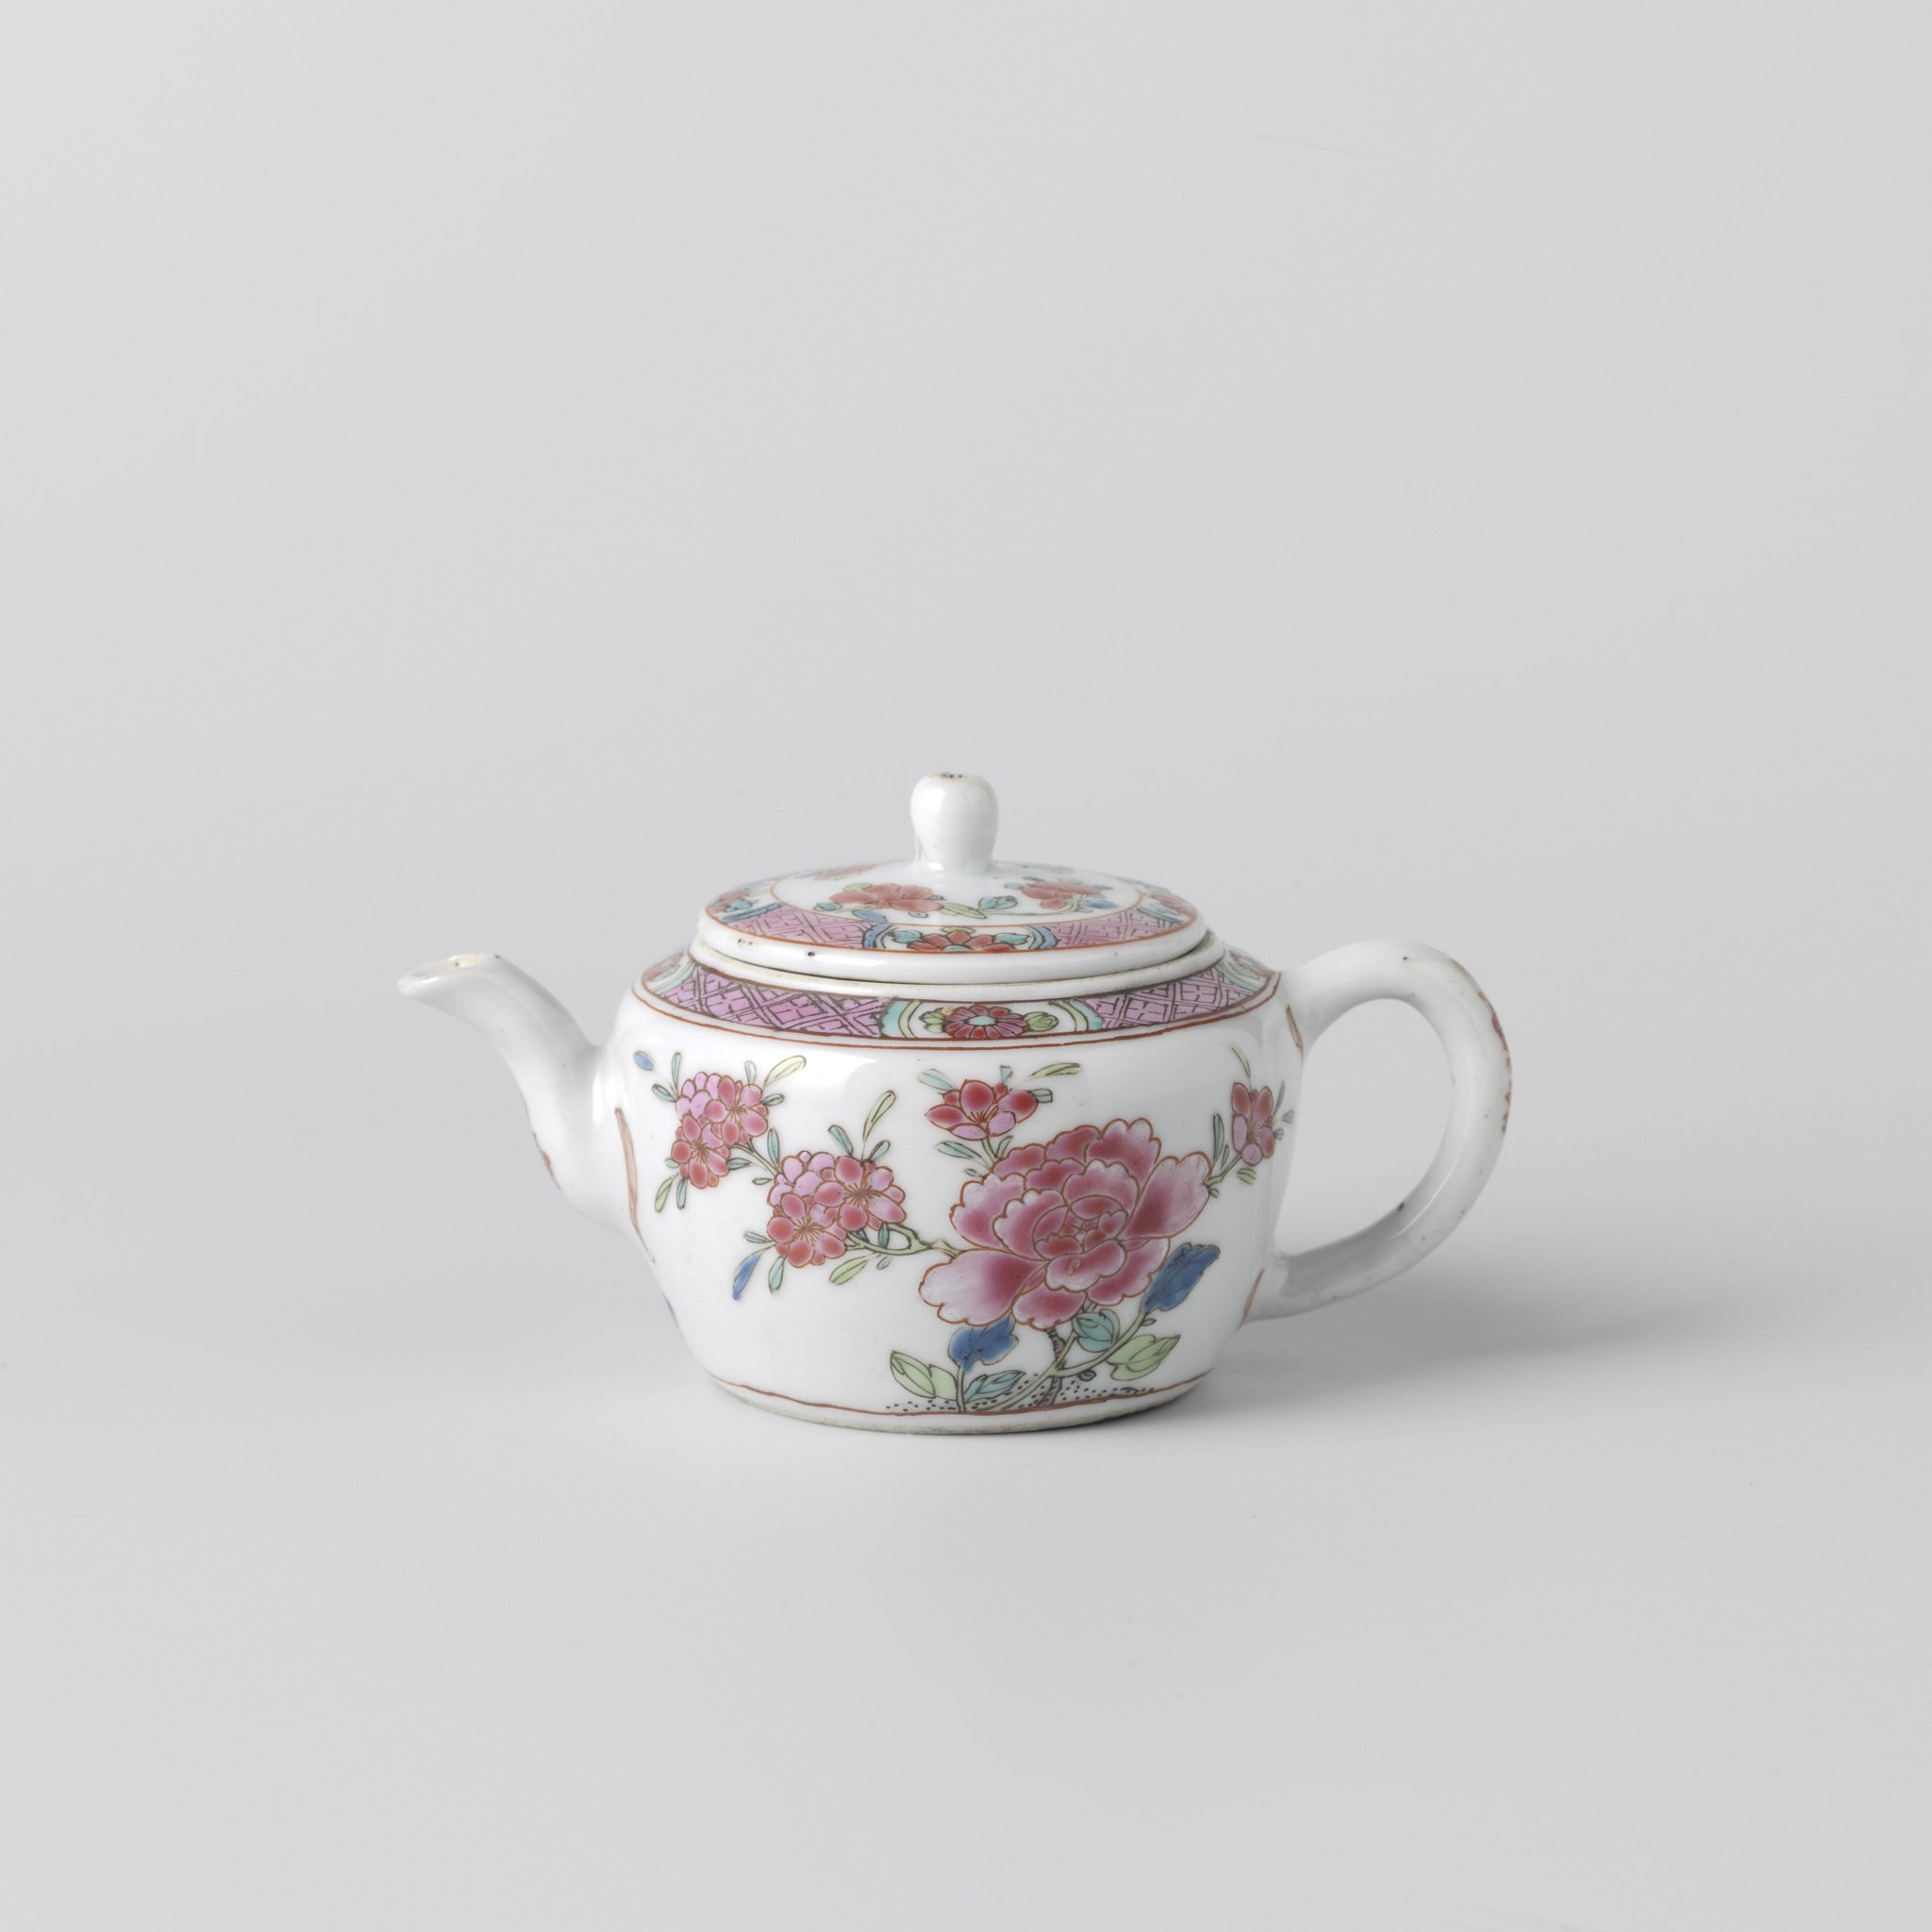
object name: teapot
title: Tea pot with flowering plants and diaper patterns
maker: Anonymous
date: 1725-1749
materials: glaze, paint, porcelain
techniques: firing, turning, vitrification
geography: china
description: Theepot van porselein met een gebogen tuit en C-vormig oor, beschilderd op het glazuur in blauw, rood, roze, groen, turquoise, aubergine en zwart. Op de wand tweemaal een bloeiende plant (pioen). Op de schouder een band met servetwerk onderbroken door bloemtakken in cartouches. De tuit en het oor met bloemranken. De deksel met dezelfde decoratie. Famille rose.